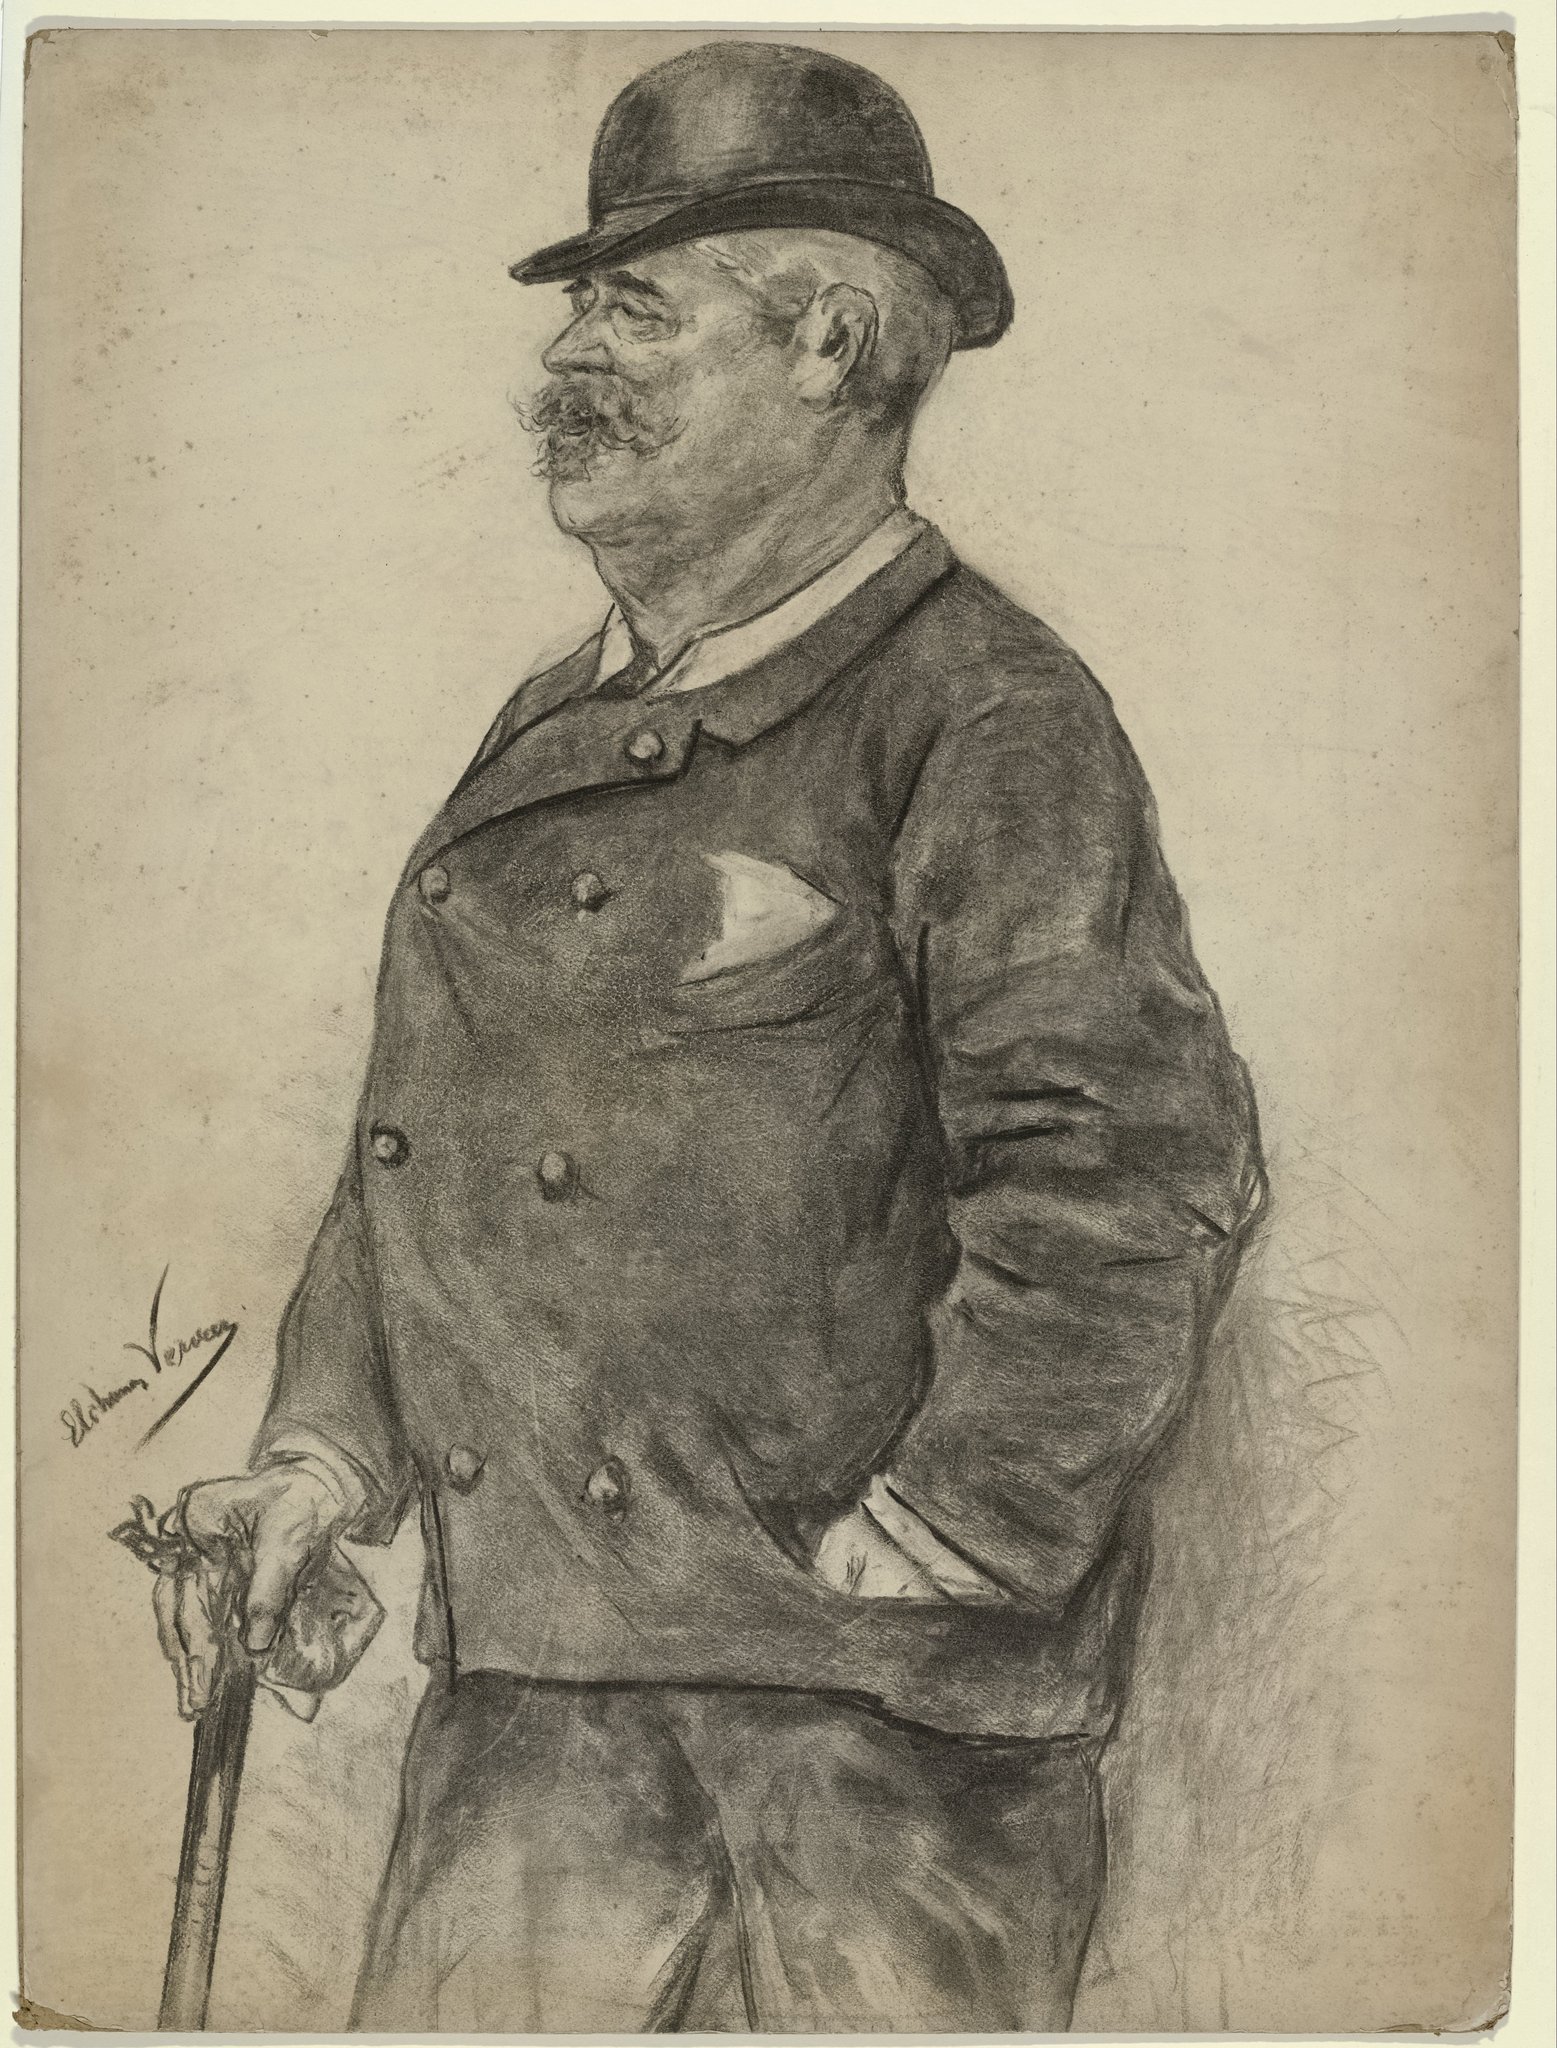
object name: caricature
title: Karikatuurportret van Mari ten Kate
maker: elchanon verveer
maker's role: draughtsman, print maker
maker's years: 1826-1900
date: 1850-1899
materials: charcoal, paper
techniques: stumping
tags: the hague, painter, print maker, draughtsman, mari ten kate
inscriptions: signature: ‘Elchanon Verveer’, inscription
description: Karikatuurportret van de kunstschilder Mari ten Kate (1831-1910) ("Johan Mari Henry").